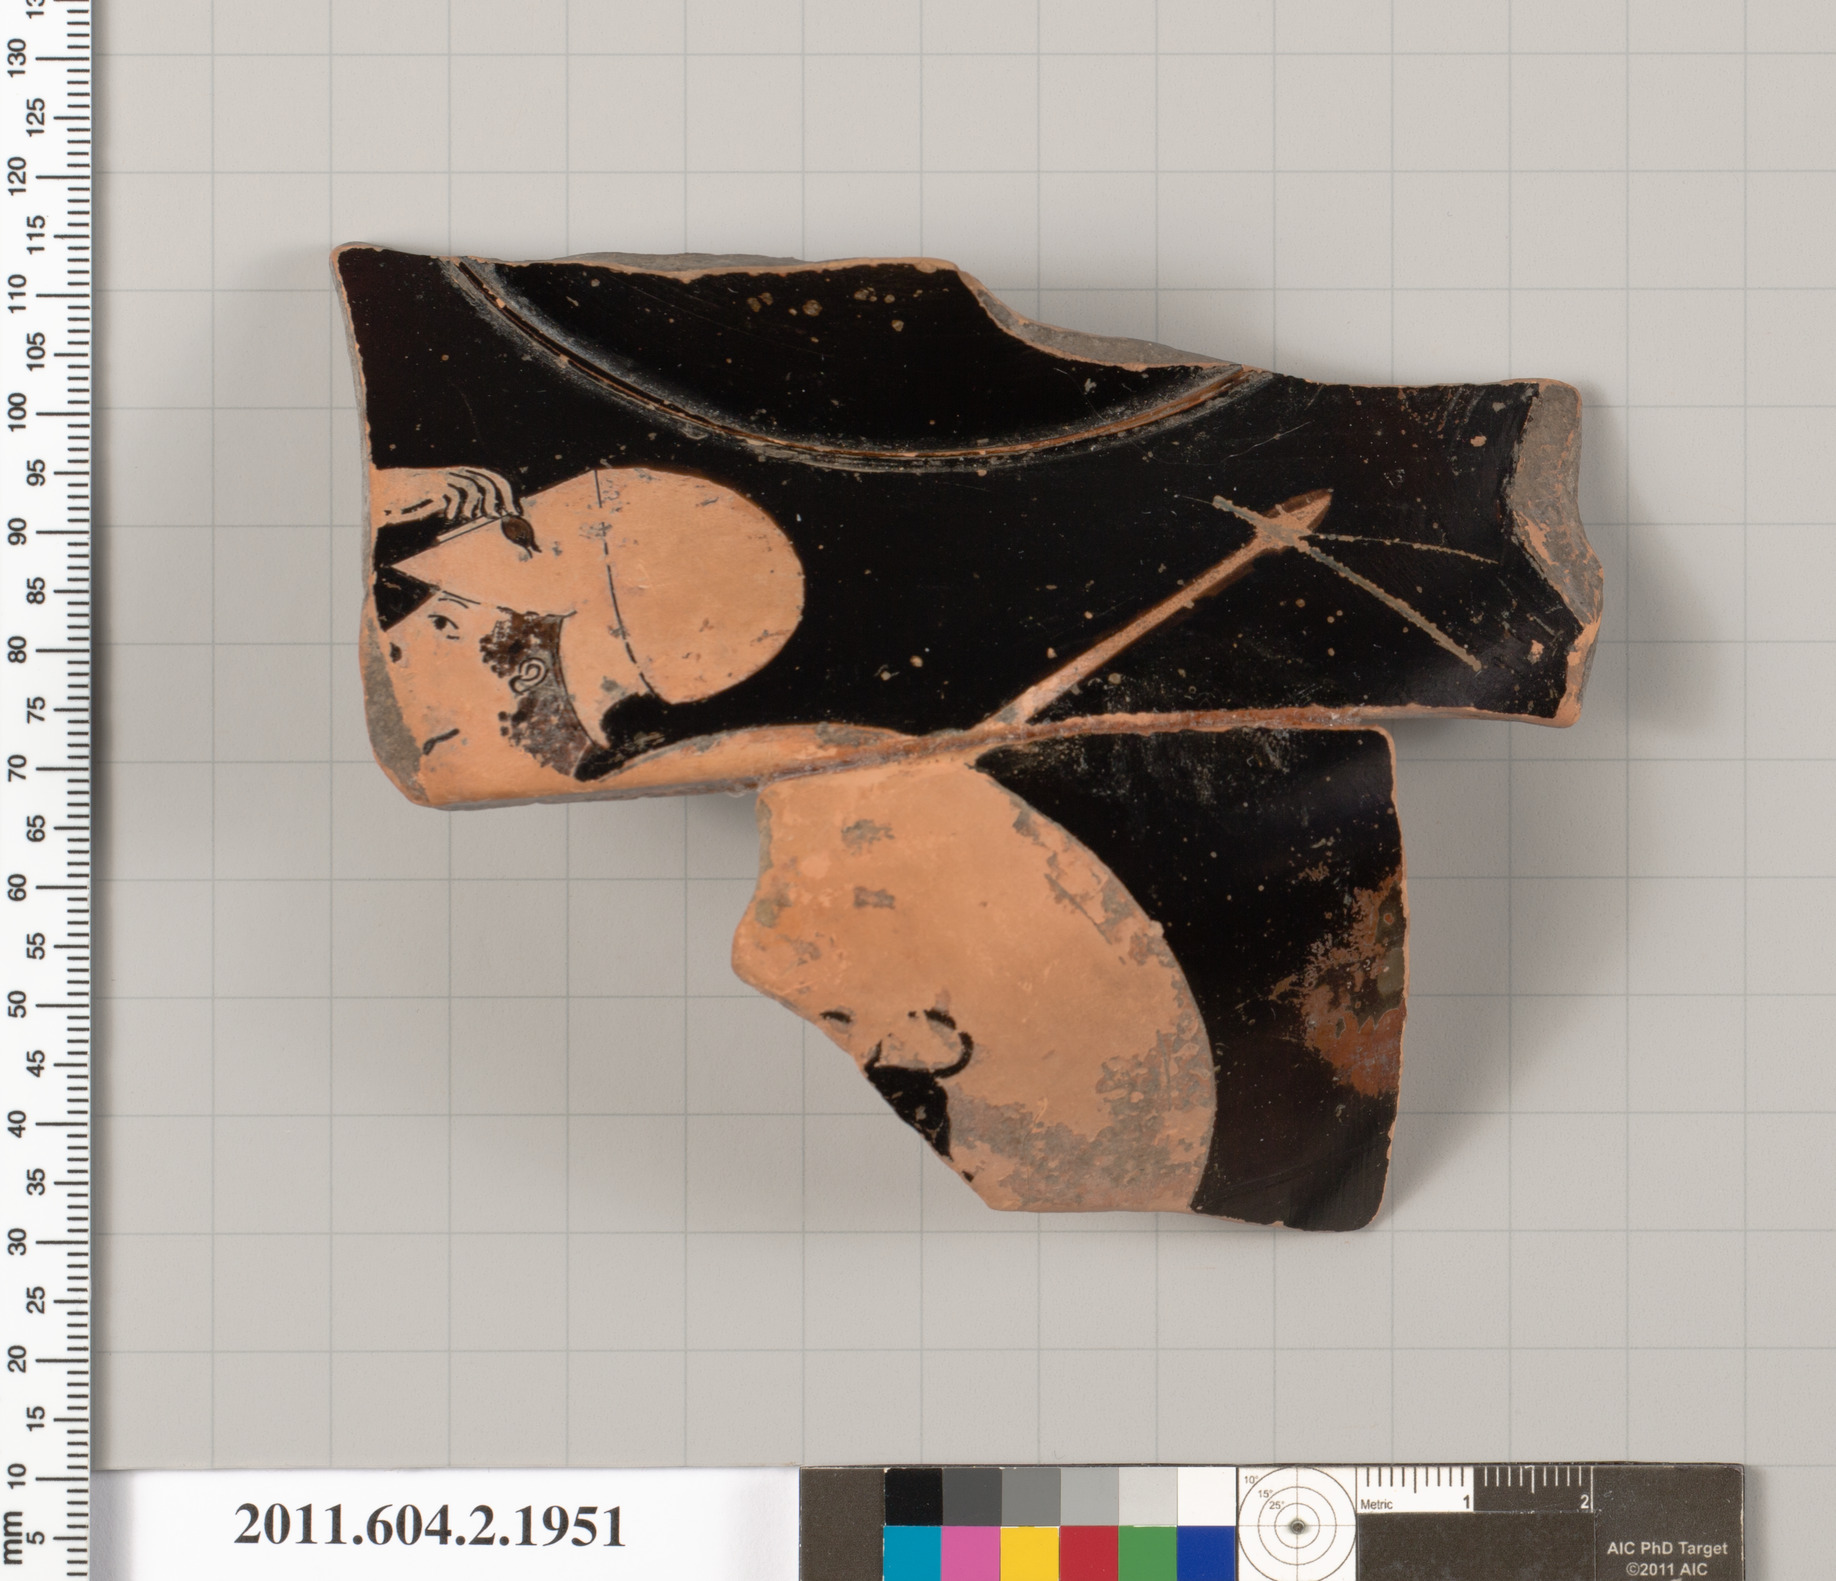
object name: neck amphora fragment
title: Terracotta fragment of a Nolan neck-amphora (jar)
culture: greek, attic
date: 475-460 BCE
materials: terracotta